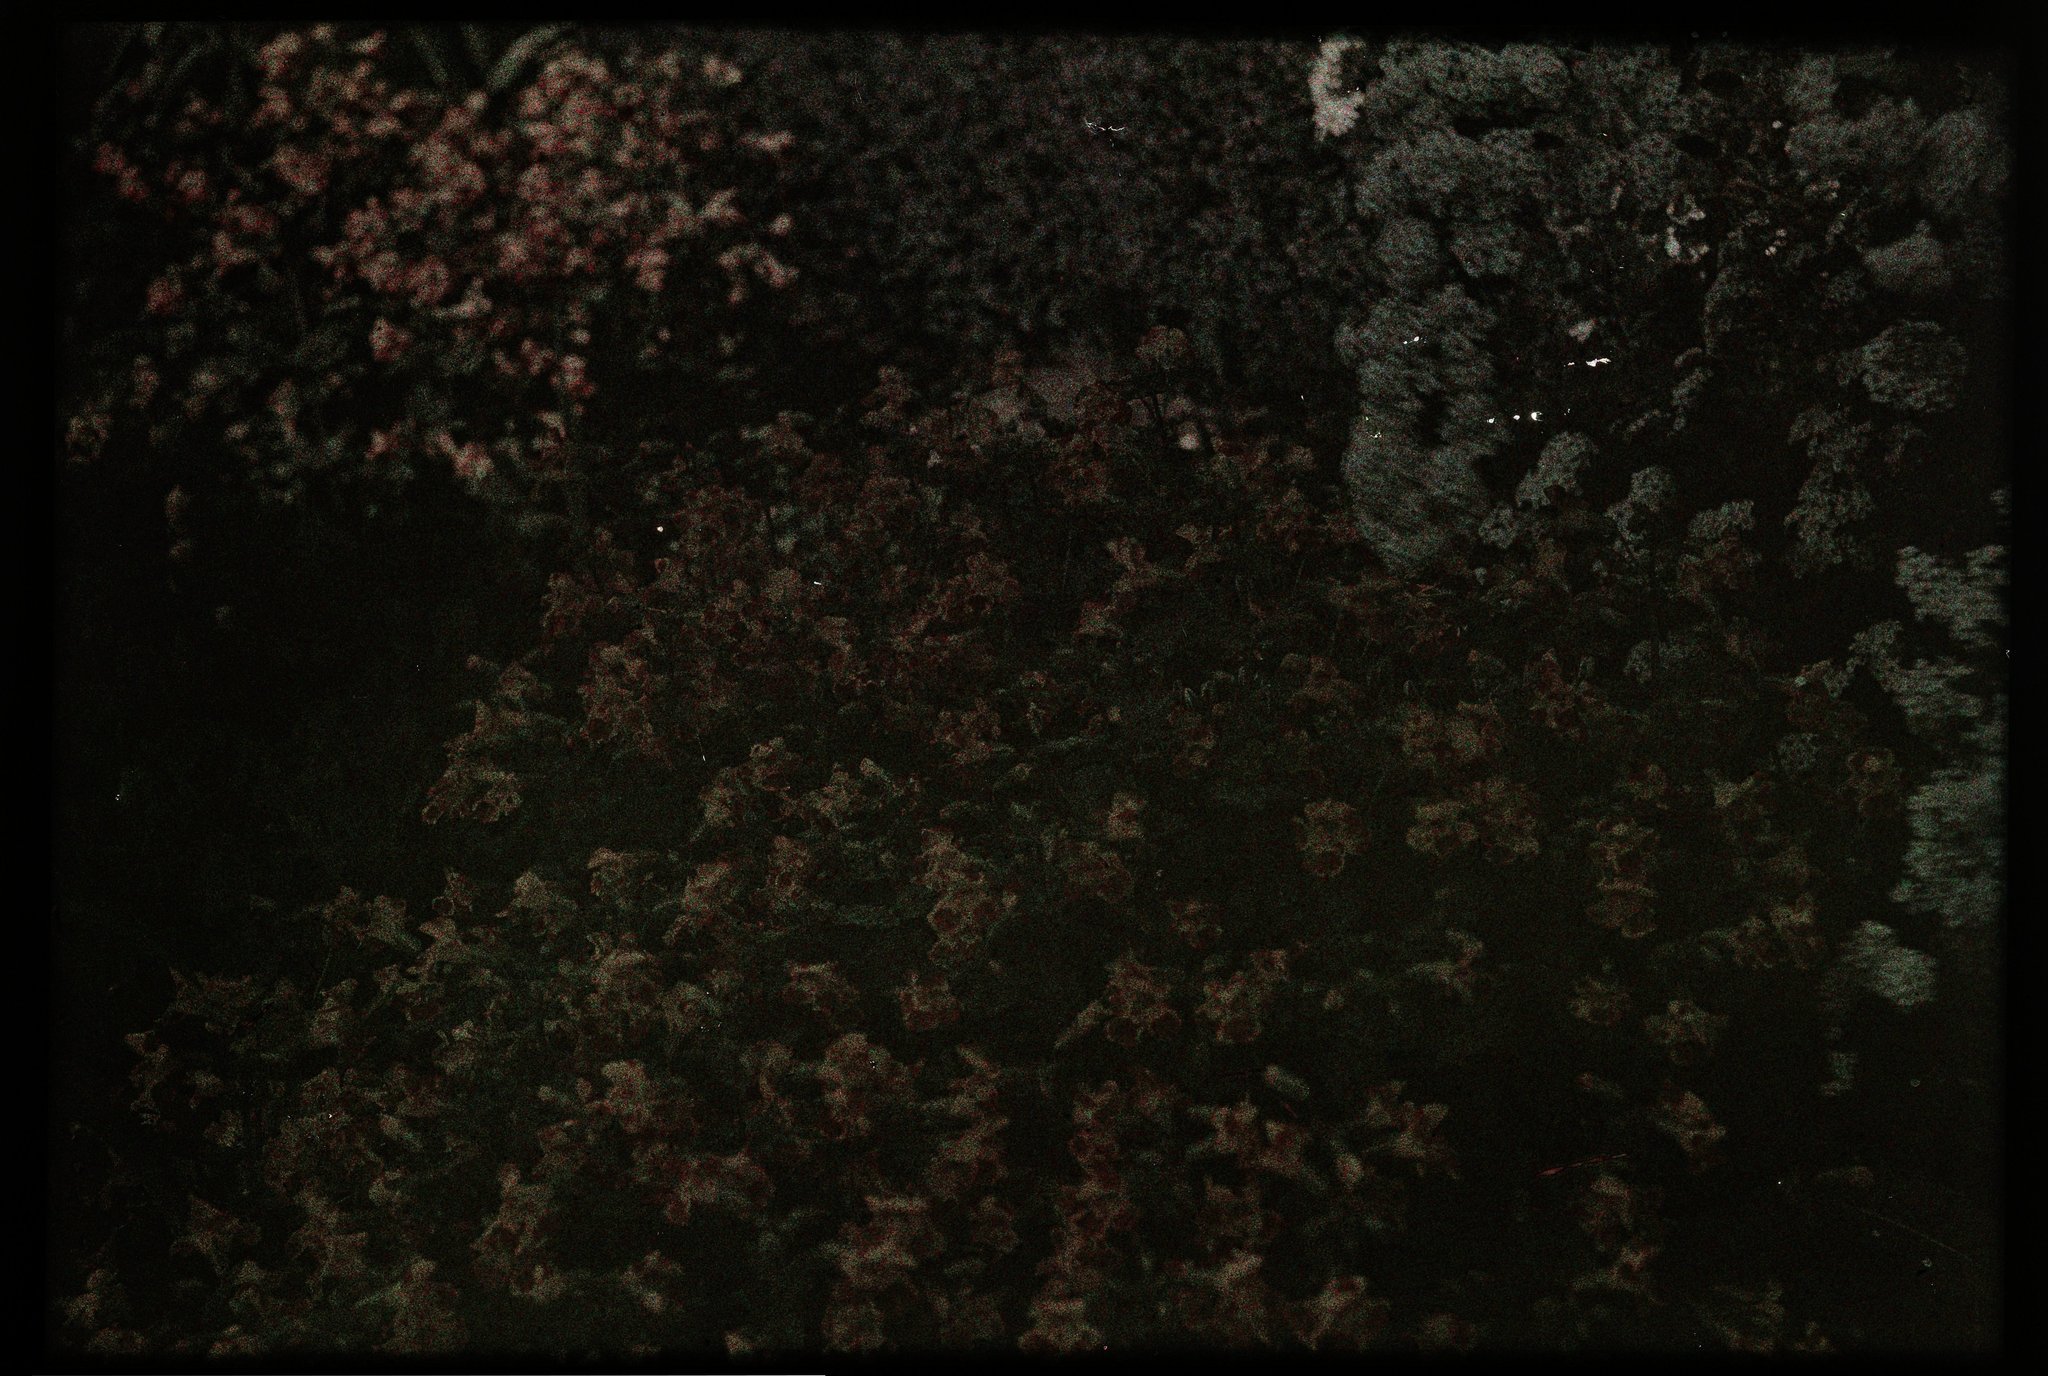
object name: photograph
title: Roze en witte bloemen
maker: adolphe burdet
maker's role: fotograaf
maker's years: 1860-1940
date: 1907-1930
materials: glass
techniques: autochrome process, slide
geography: netherlands